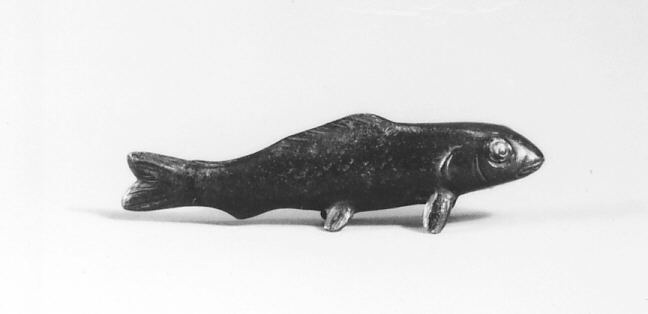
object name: figurine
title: Fish Figurine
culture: japanese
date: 1901-2000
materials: bronze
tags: fish